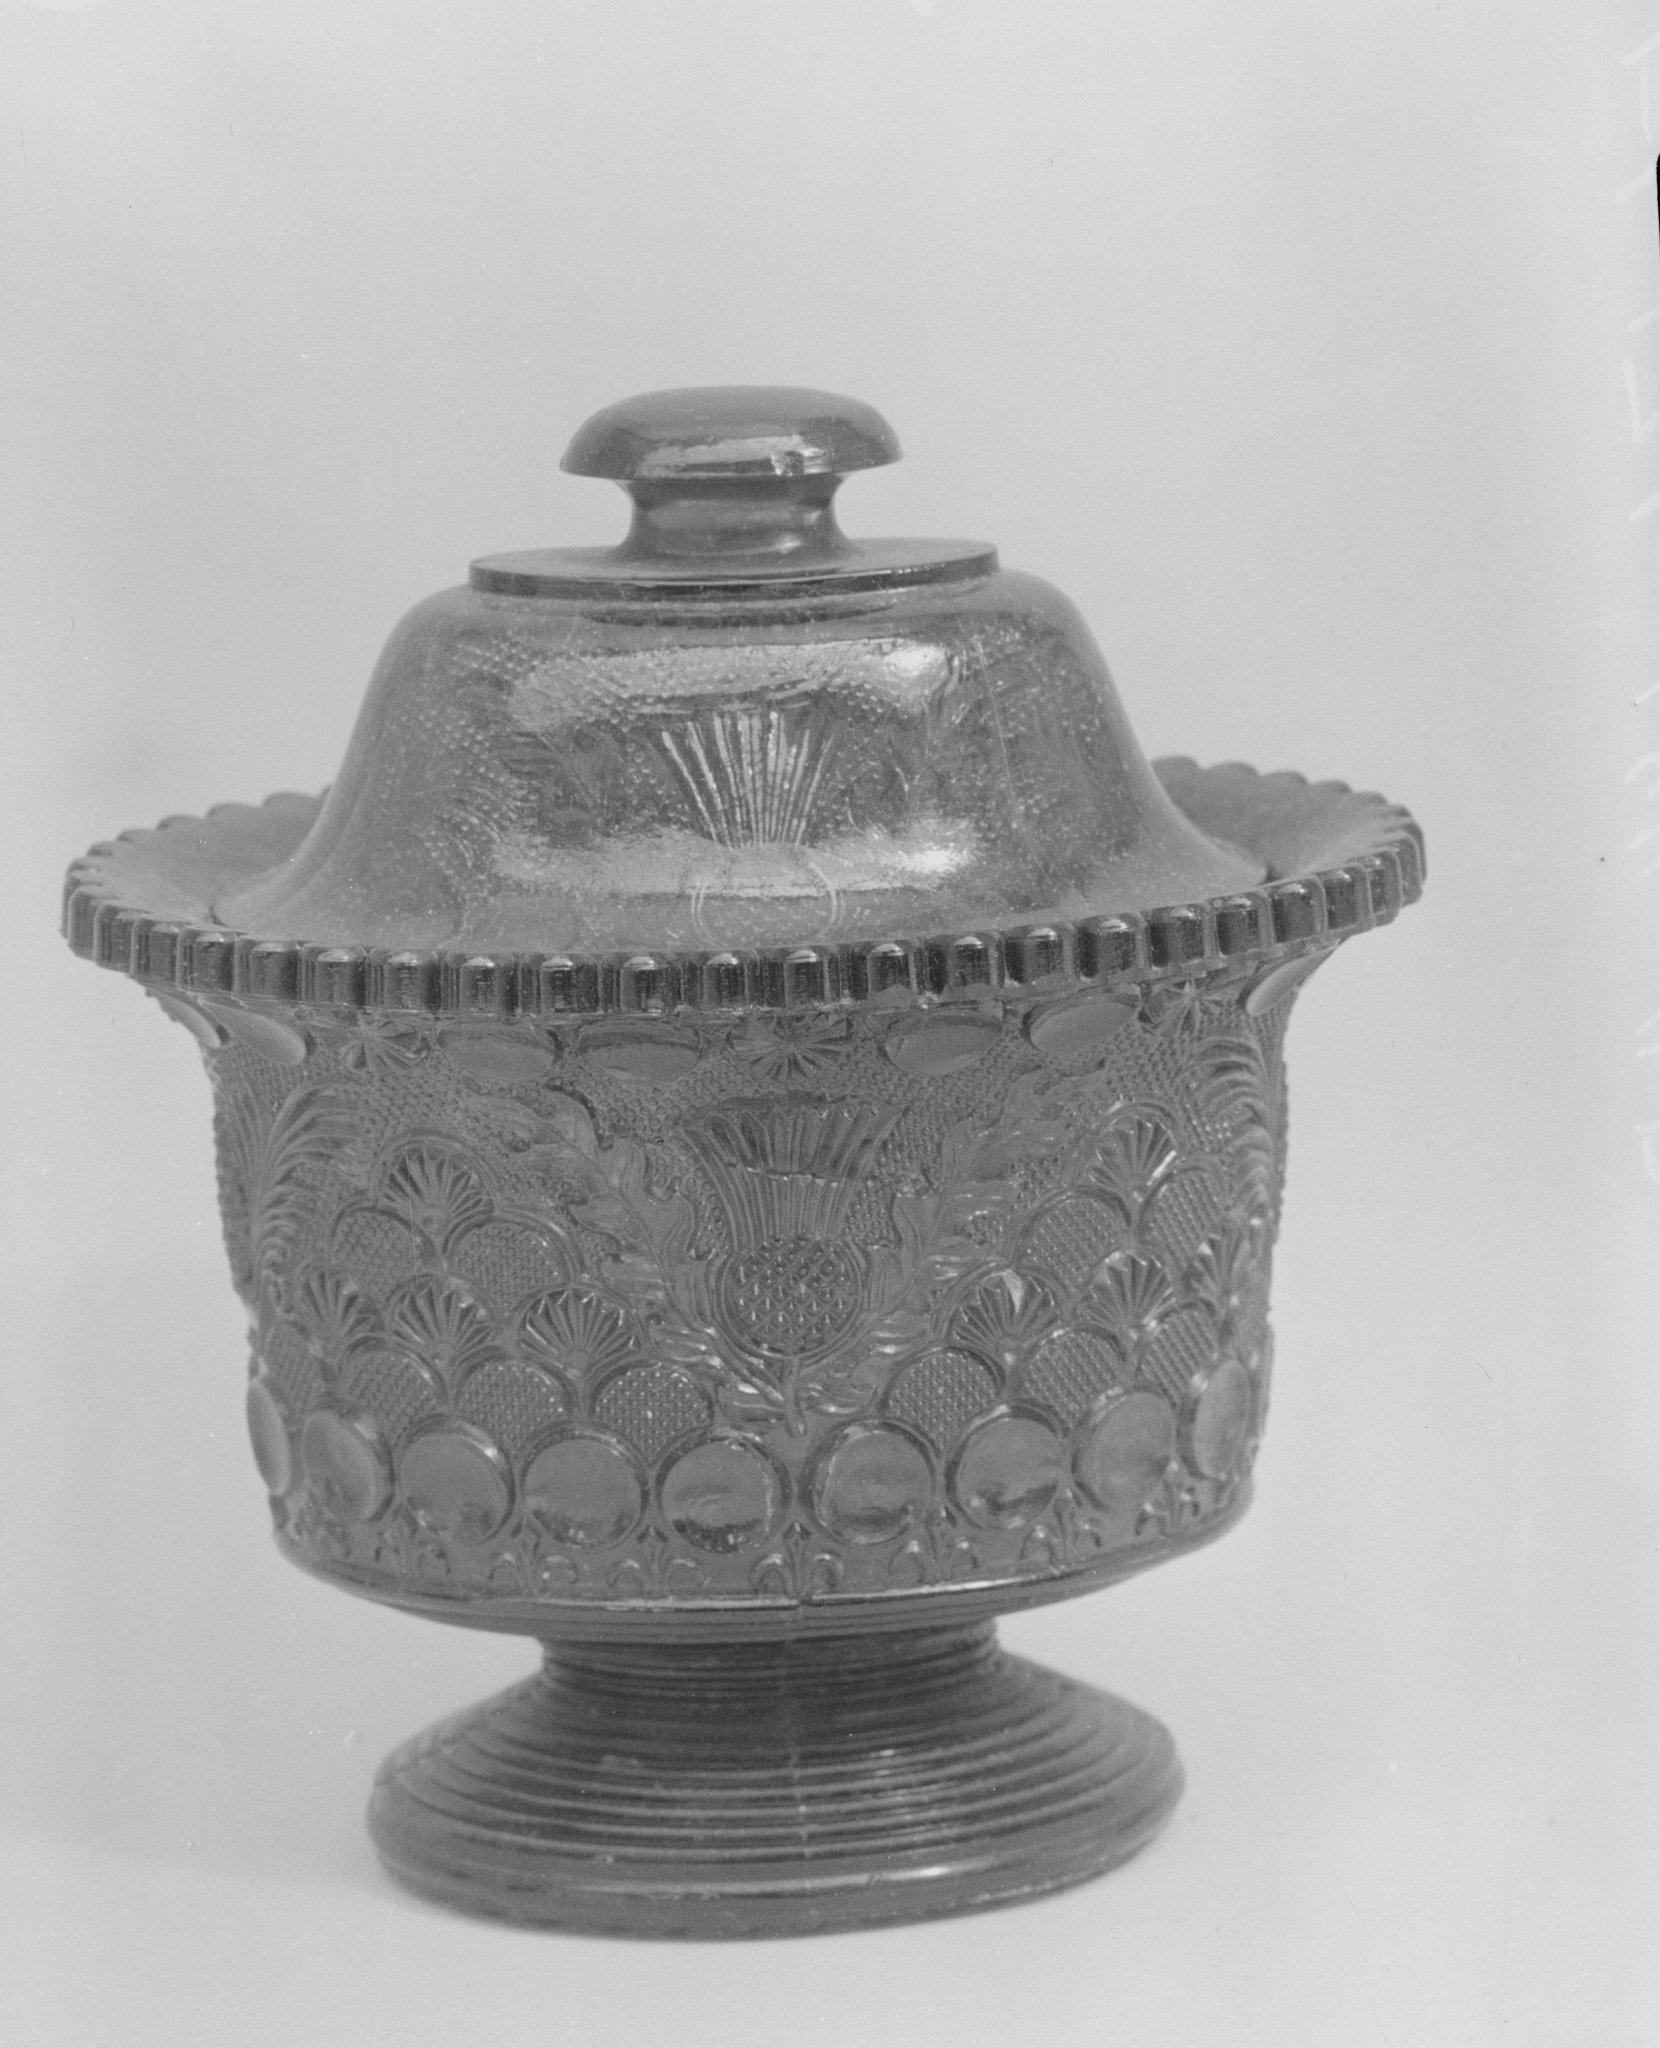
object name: sugar bowl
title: Covered Sugar Bowl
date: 1801-1900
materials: glass